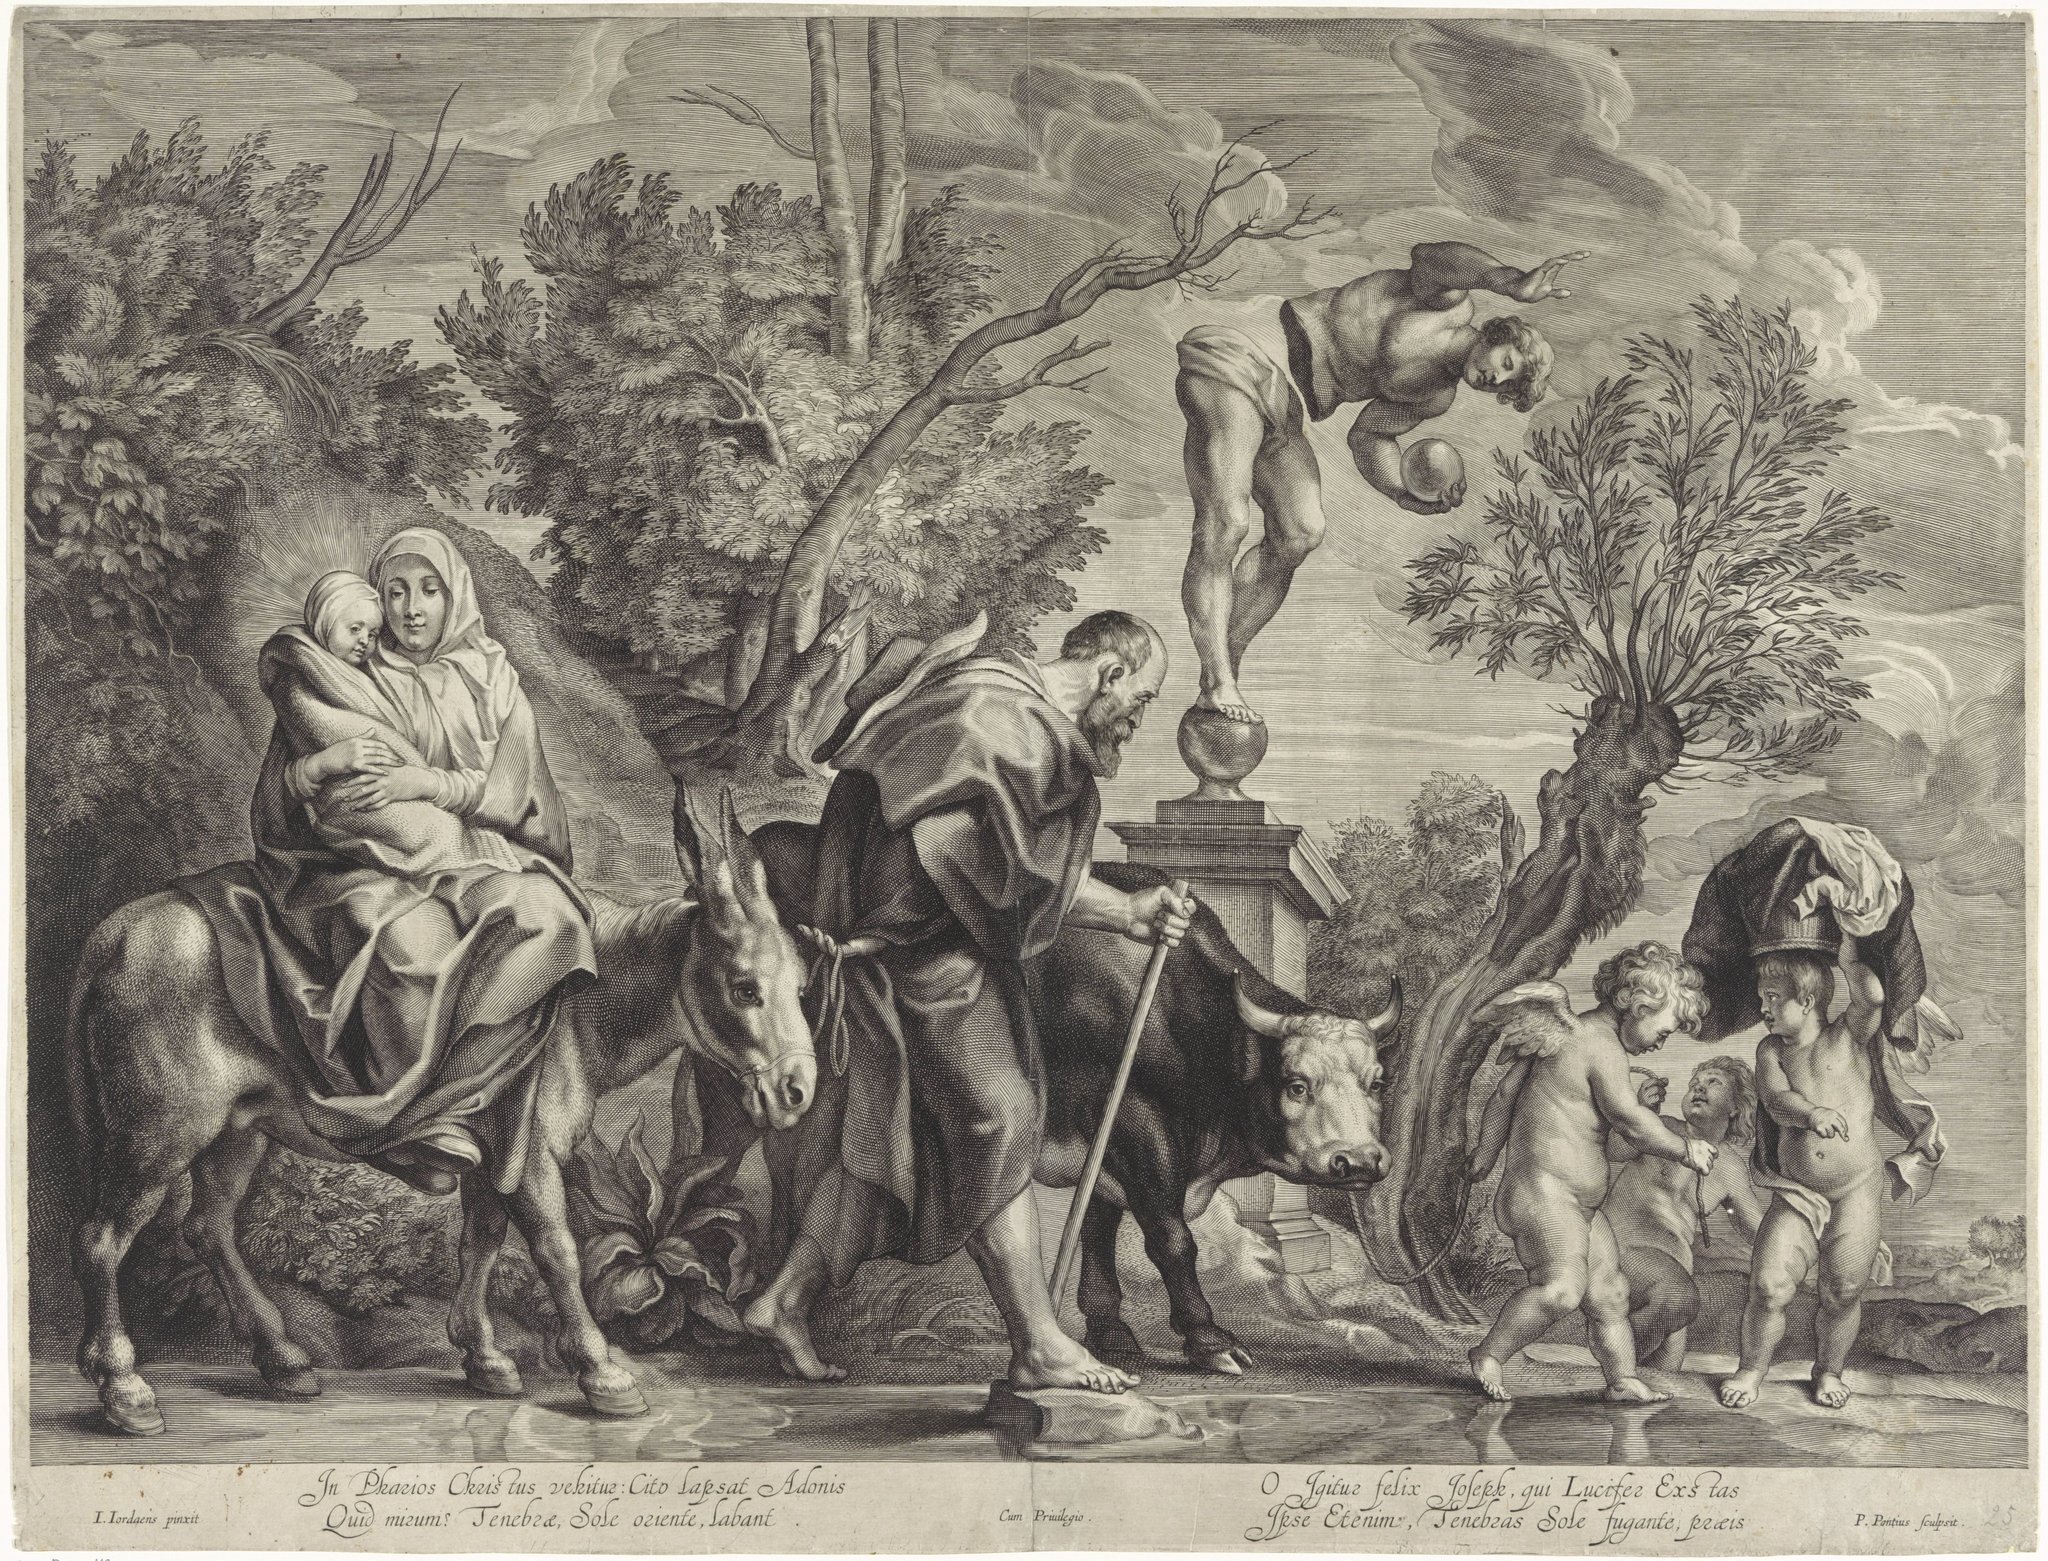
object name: print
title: Vlucht naar Egypte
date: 1616-1657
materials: paper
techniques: engraving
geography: antwerp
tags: falling of the idols ~ miracles during the flight into egypt, the flight into egypt: mary, joseph, the child (and sometimes others) on their way; mary usually riding on an ass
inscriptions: collector's mark: Lugt 2228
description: Landschap met Maria, die met het Christuskind in de armen, op de ezel rijdt. Jozef leidt het dier aan de teugels. Ze worden begeleidt door engeltjes die een os meevoeren. Het gezelschap rijdt langs een heidens beeld dat prompt in stukken uiteen valt. In de marge een tweeregelig onderschrift, in twee kolommen, in het Latijn.